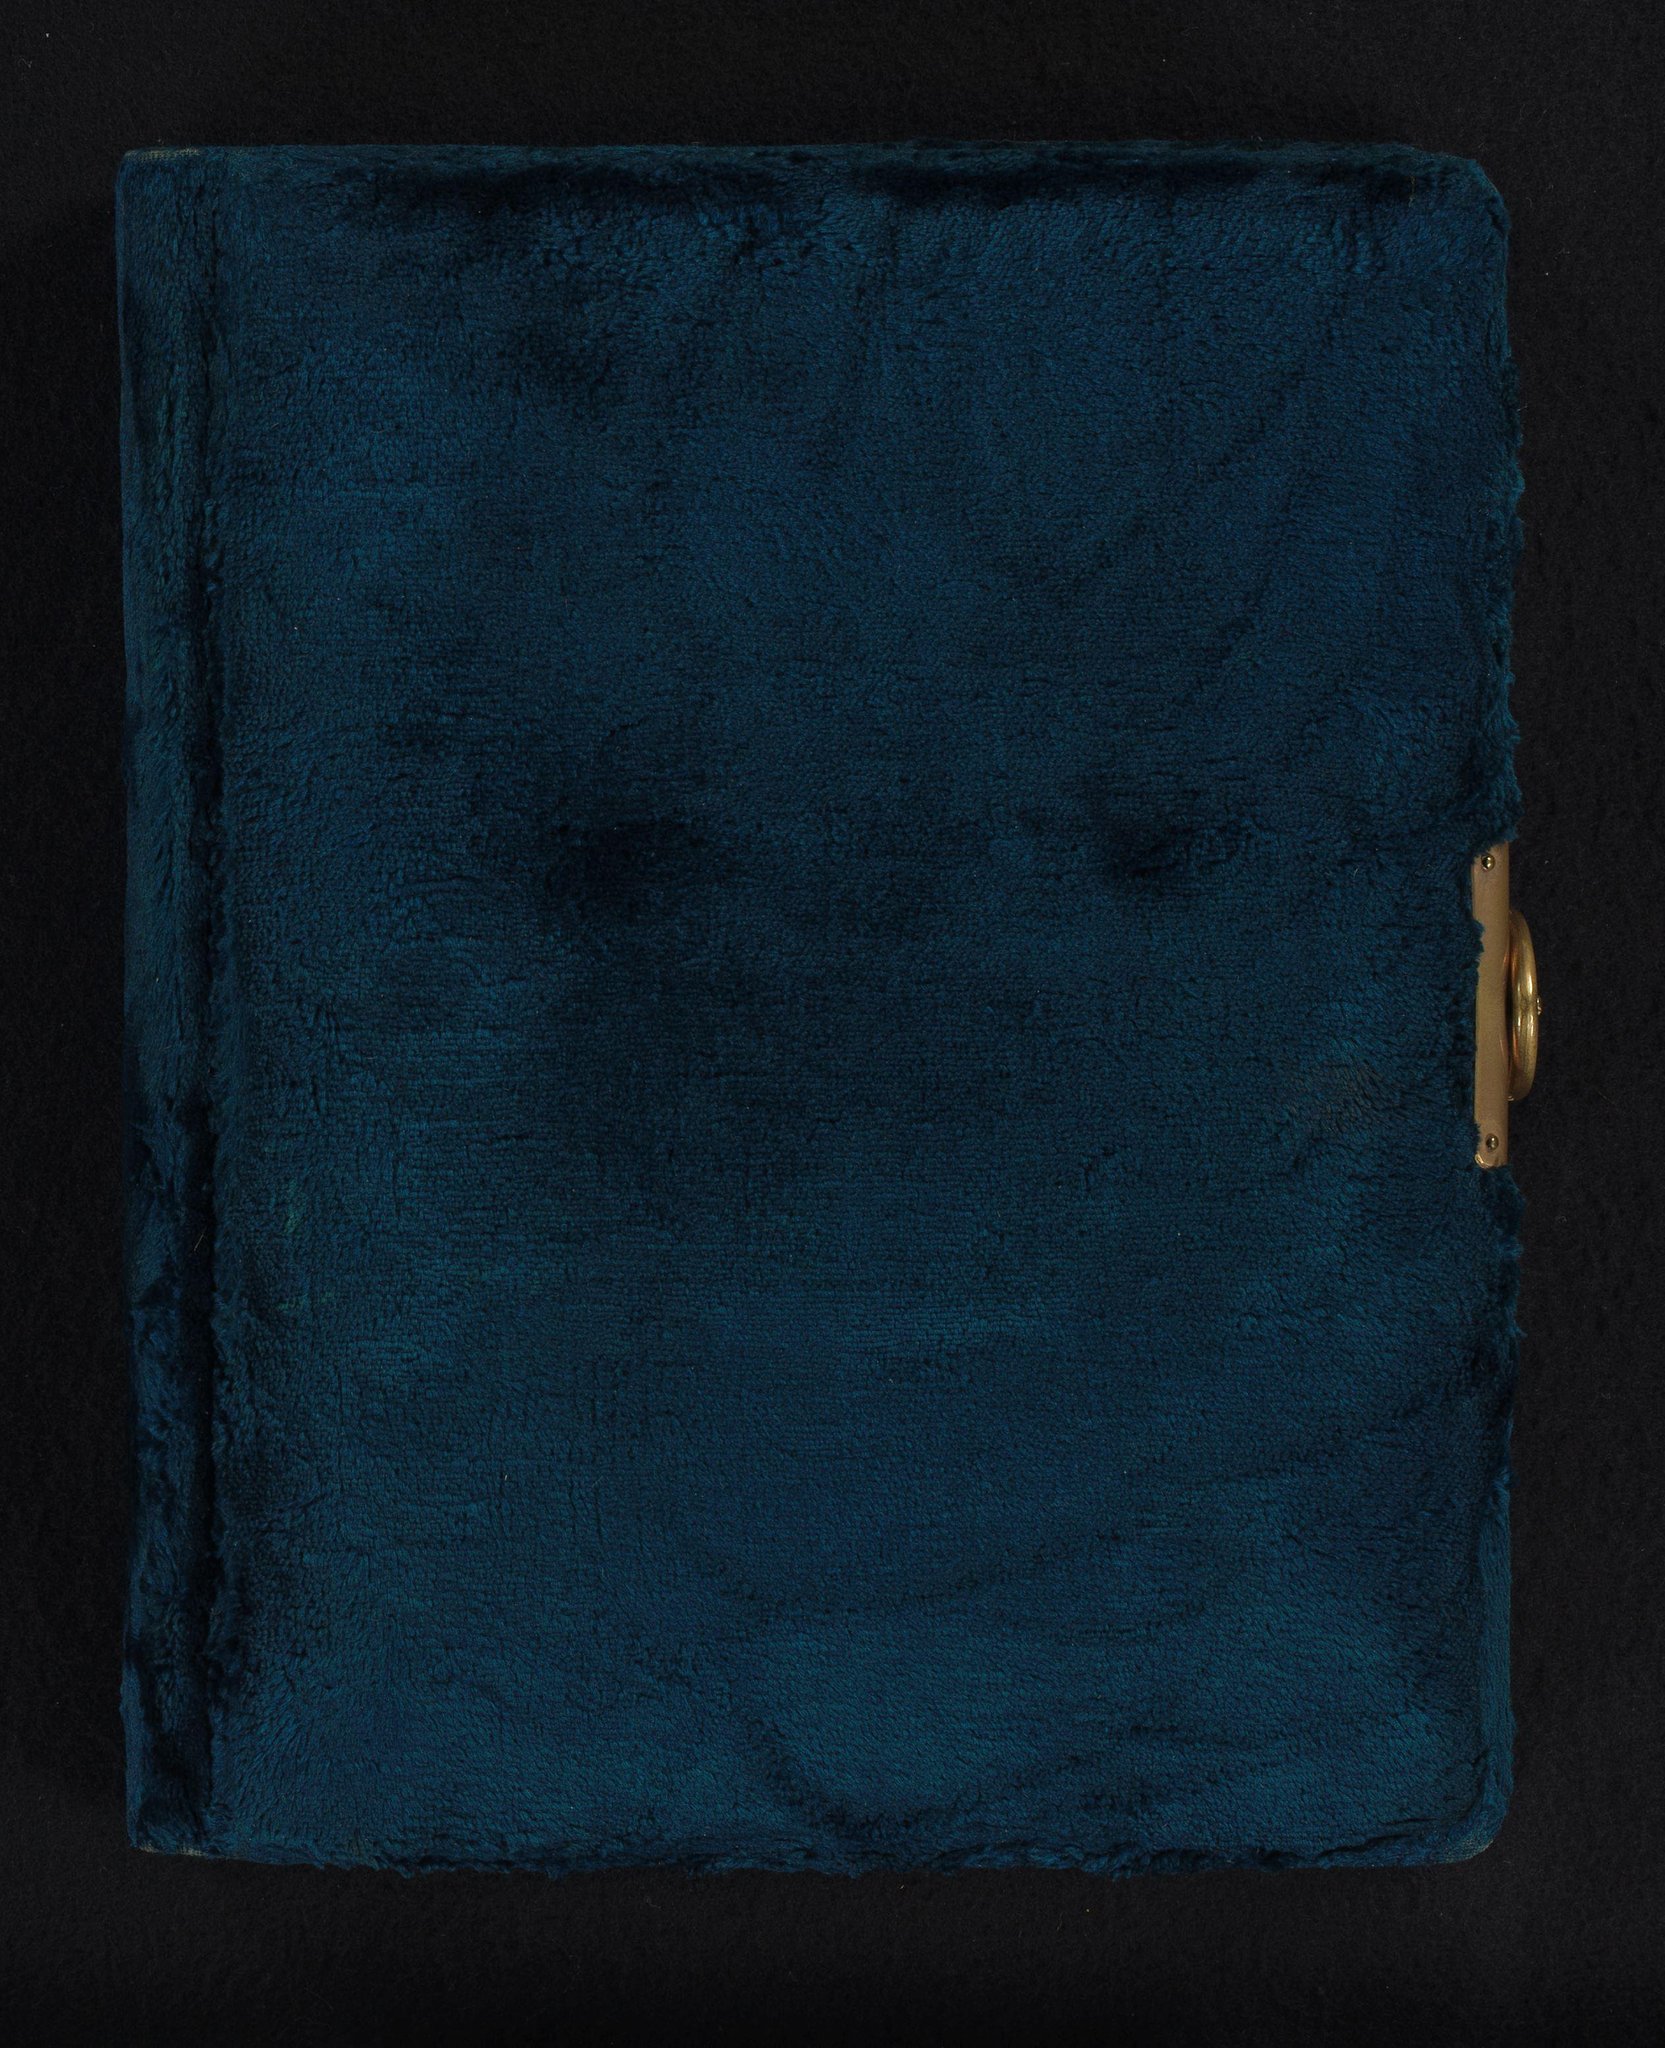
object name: slip in album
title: Fotoalbum (leeg)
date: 1860-1900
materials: cardboard, metal, paper, textile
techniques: color on snow, four-color autotype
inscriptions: monogram: ‘RB’, collector's mark: ‘DIENST/ VERSPREIDE/ RIJKSKOLLEKTIES/ (...) A 887’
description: Fotoalbum met acht bladen met op ieder blad een passe-partout voor een kabinetfoto. De passe-partouts zijn omkaderd door decoraties van bloemen in vierkleurenautotypie, waarop het monogram RB is vermeld.